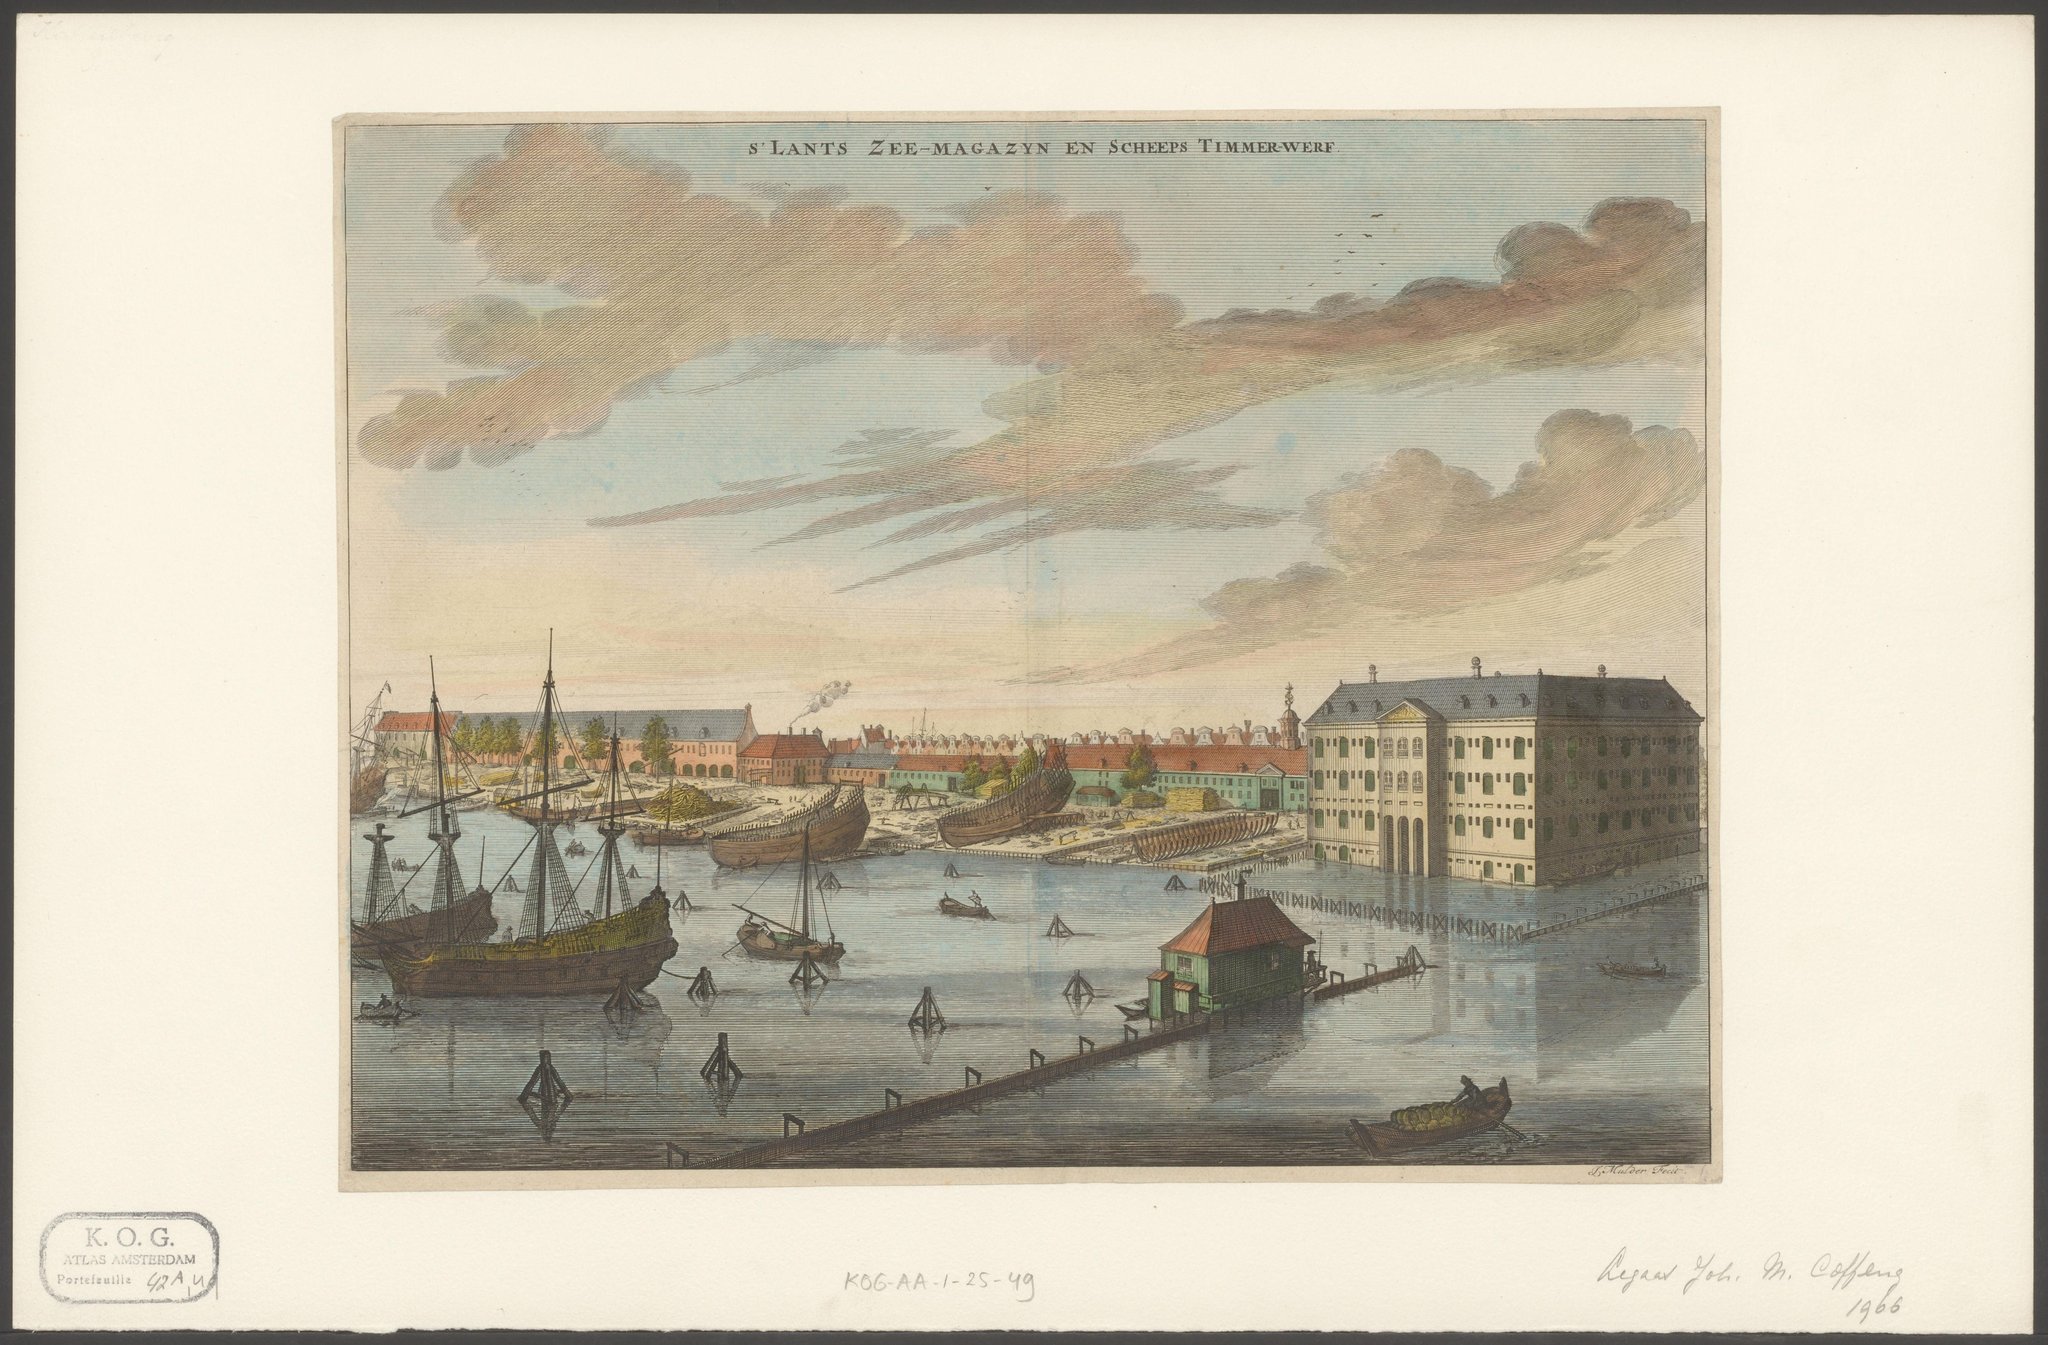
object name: book illustration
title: s' Lants Zee-magazyn en Scheeps Timmer-werf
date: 1726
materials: paper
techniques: engraving, etching, hand coloring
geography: amsterdam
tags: large-scale structure for storage, e.g.: warehouse, depot, silo, shipyard, shipdock, ammunition store, arsenal, shipbuilding industry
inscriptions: collector's mark: ‘42A.49’ Lugt 1641b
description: Prent waarschijnlijk uit: Commelin, Caspar. Beschryvinge van Amsterdam, zynde een naukeurige verhandelinge van desselfs eerste oorspronk uyt (…). 2 dln. 2de druk. Amsterdam: Andries van Damme, Johannes Ratelband, weduwe A. van Aeltwyk en Hermanus Uytwerf, 1726. Eerdere staat van prent (RP-P-AO-25-58) gebruikt in uitgaven uit 1693 en 1694.